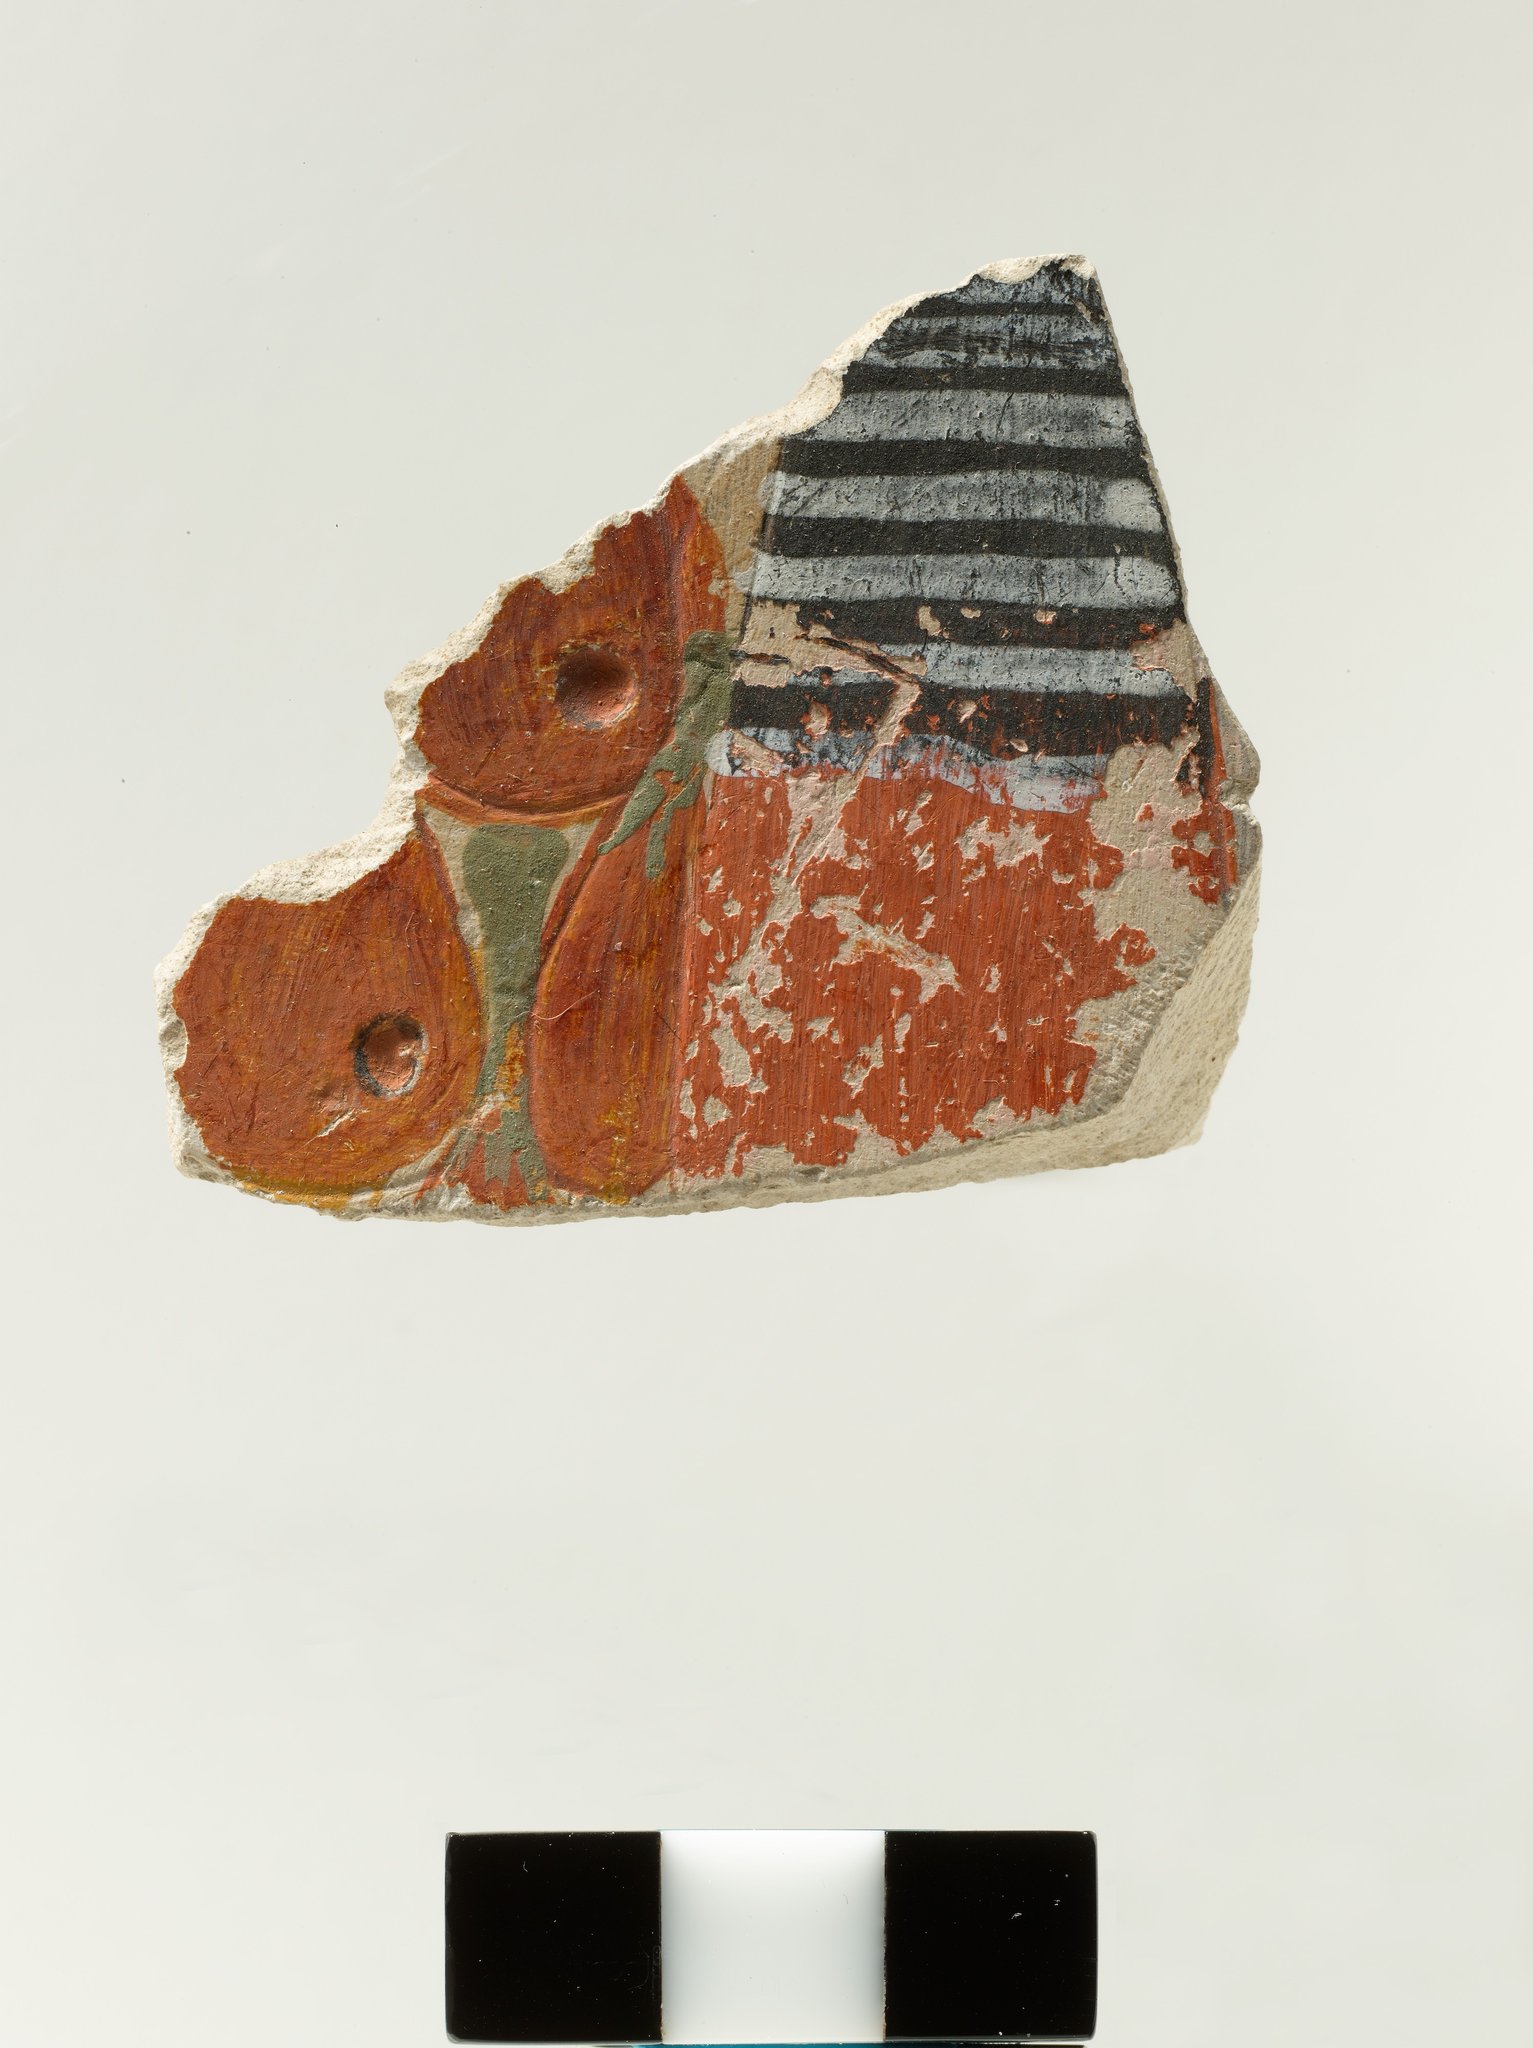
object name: relief fragment, tomb of meketre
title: Relief fragment from the tomb of Meketre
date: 1981-1975 BCE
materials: limestone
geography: egypt